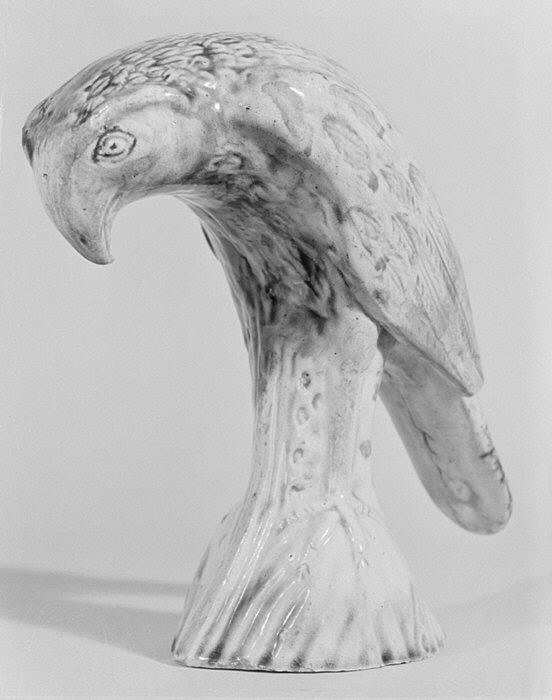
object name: figure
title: Parrot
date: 1760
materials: earthenware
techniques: glazing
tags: parrots